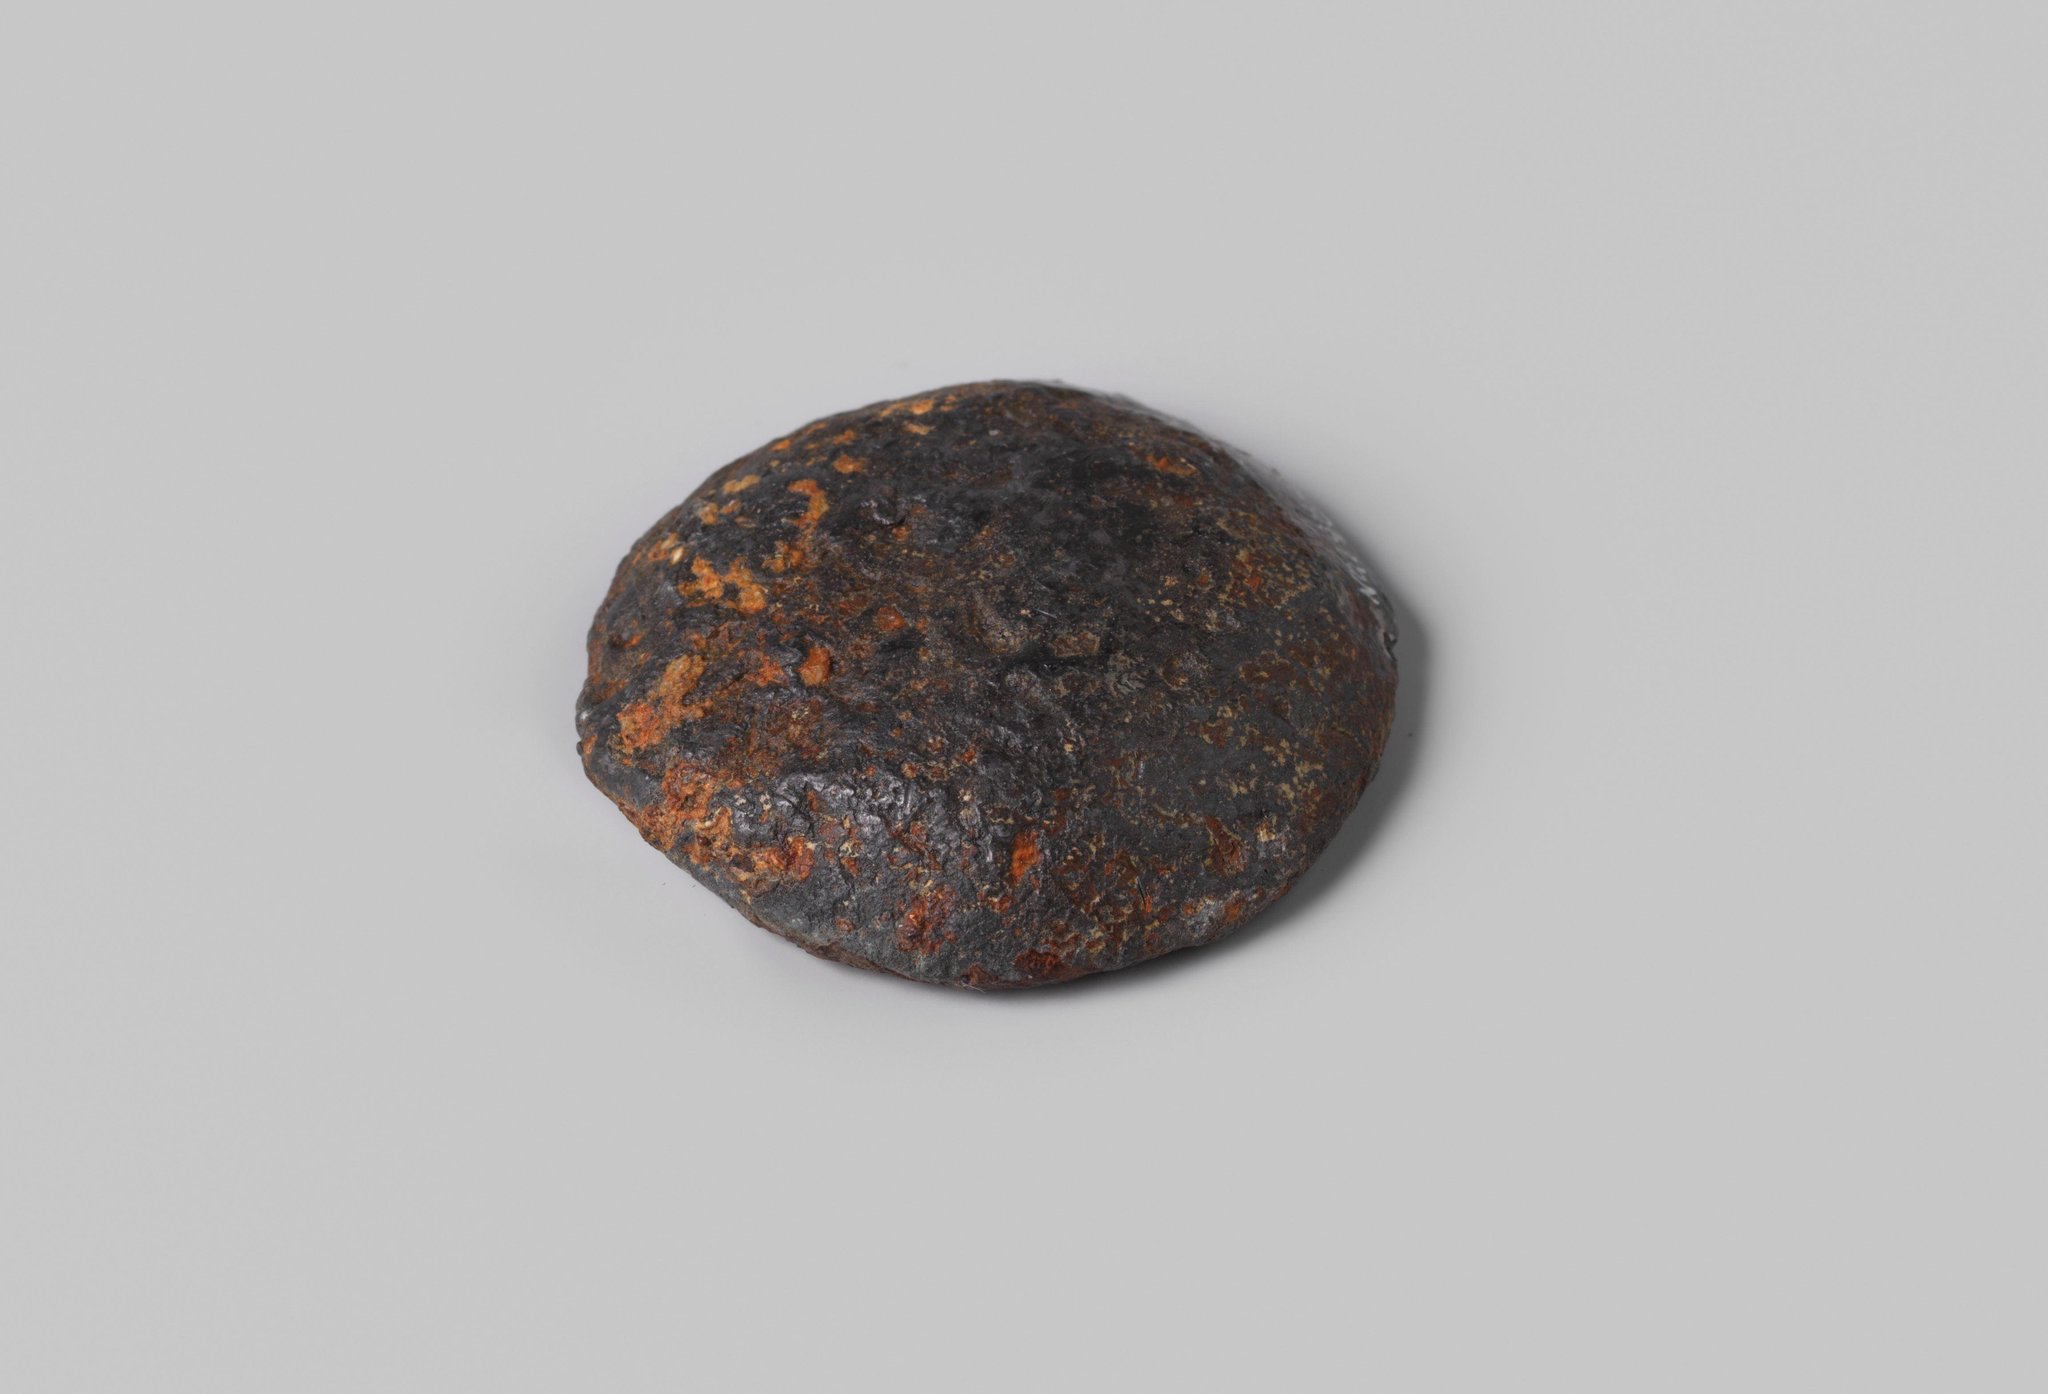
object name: weight scale component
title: Gewicht uit het wrak van de Oost-Indiëvaarder Hollandia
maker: Anonymous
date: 1700-1743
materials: lead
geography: netherlands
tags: verenigde oostindische compagnie, hollandia (schip), annet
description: Disc-shaped weight, sim. NG 1980-27H2928, eroded